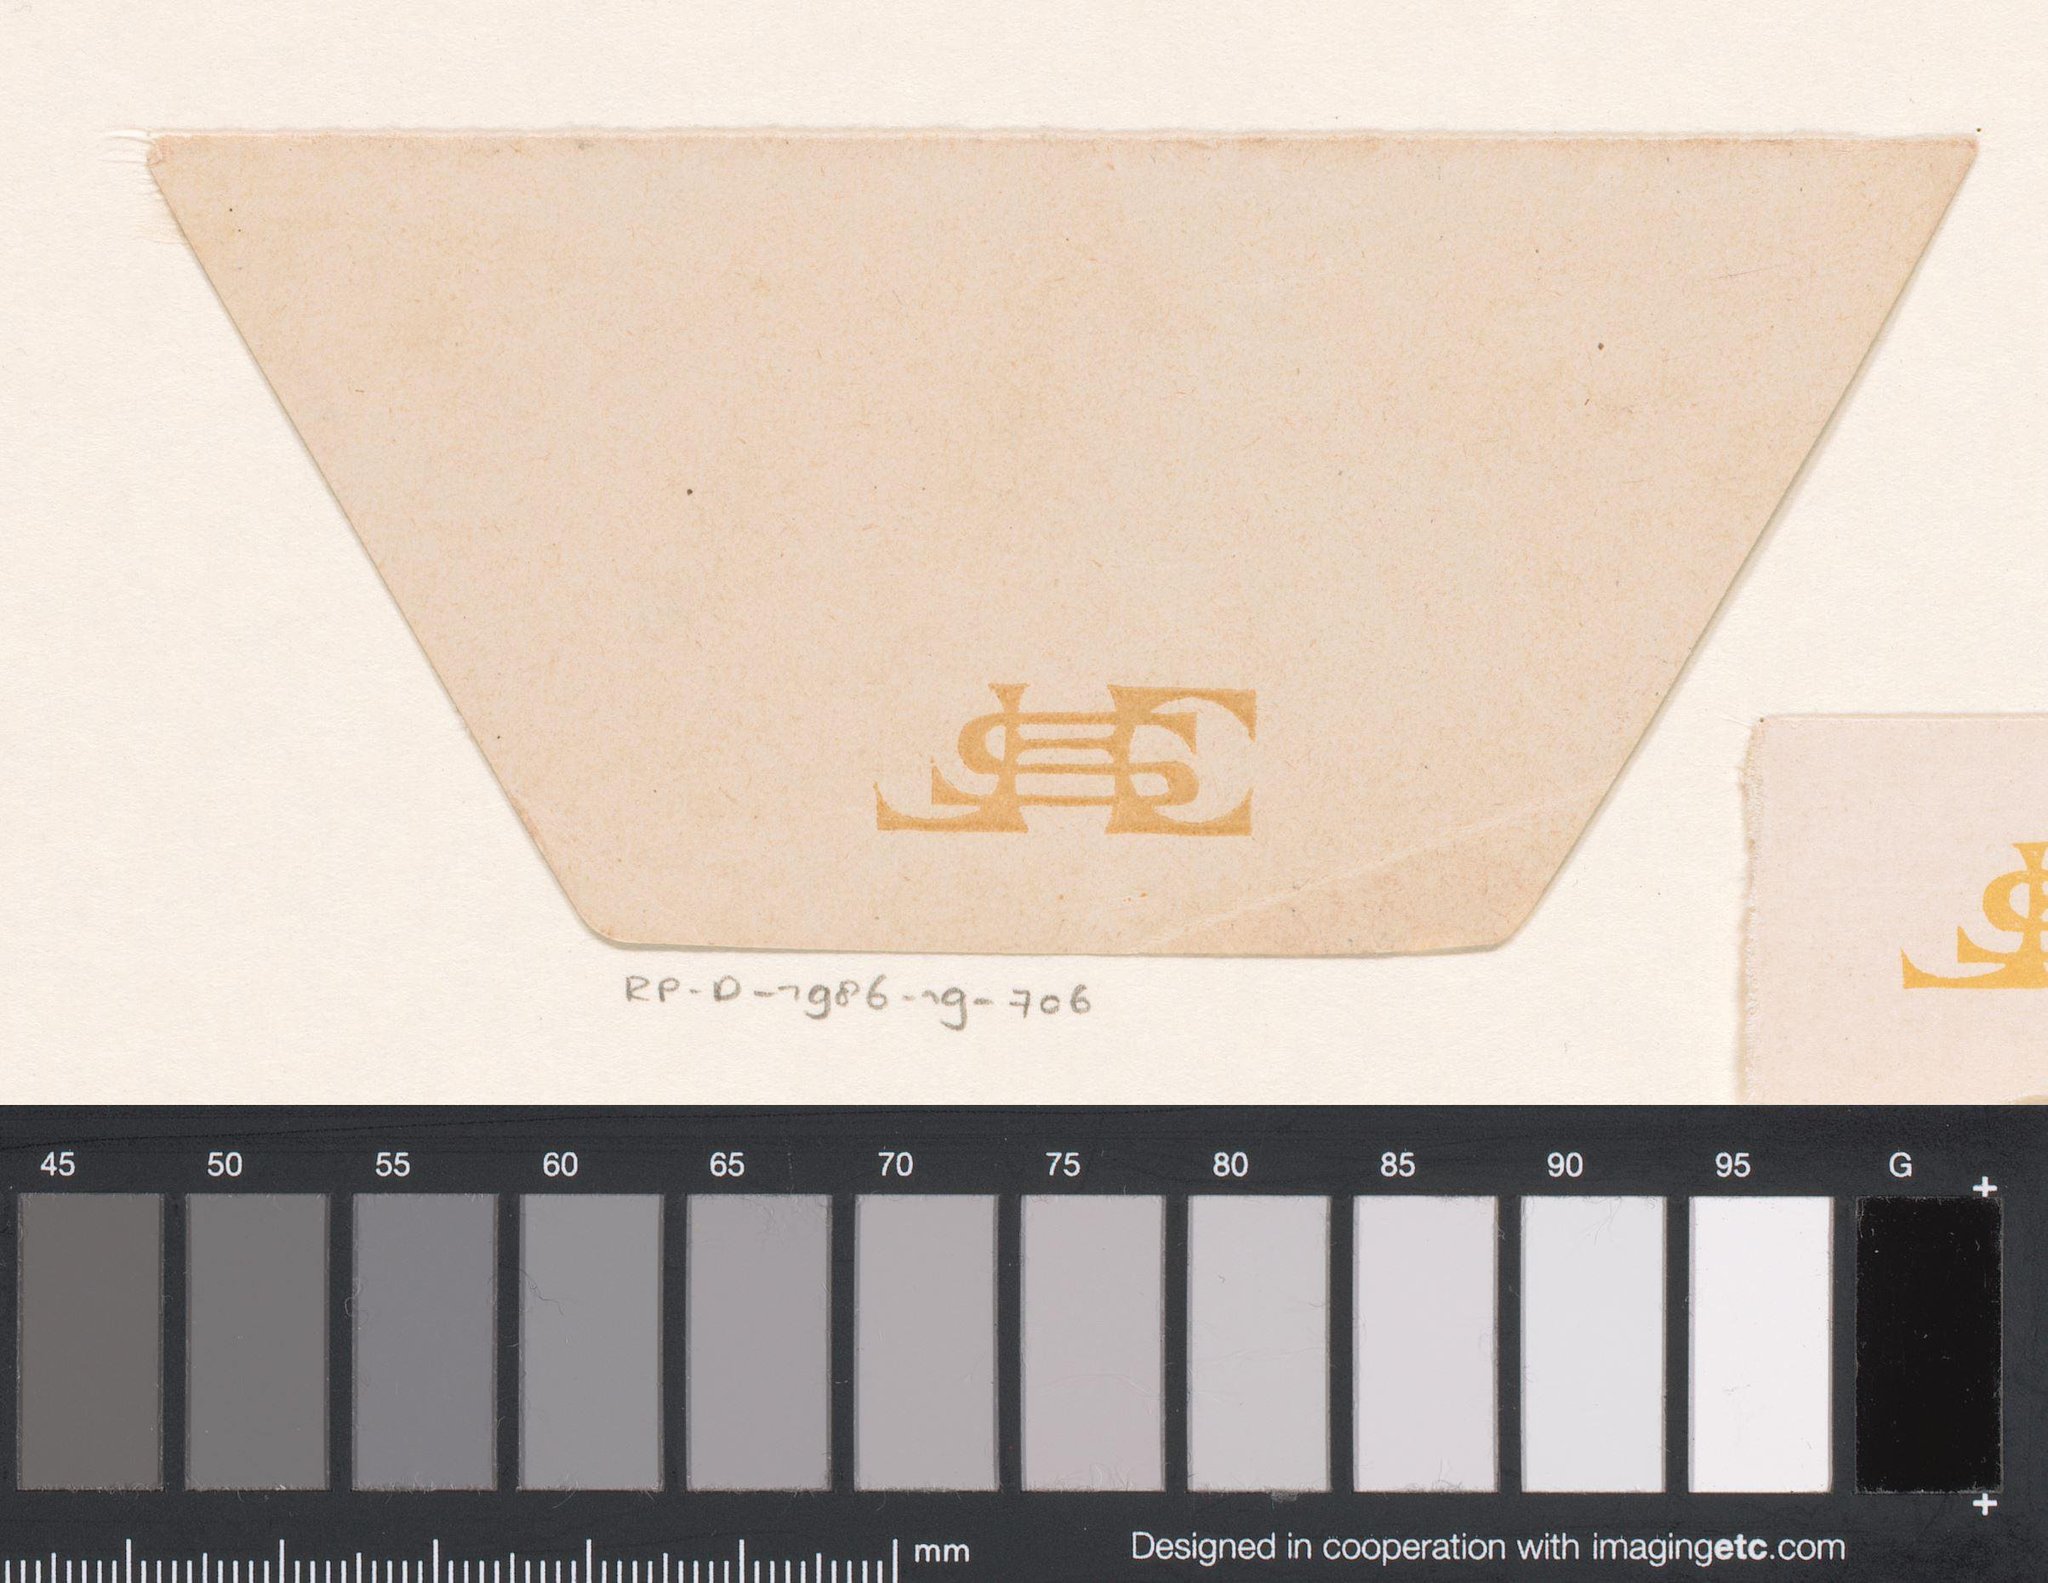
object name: photomechanical print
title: Monogram SHLC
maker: reinier willem petrus de vries (1874-1953)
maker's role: draughtsman, print maker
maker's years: 1874-1953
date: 1884-1952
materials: paper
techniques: printing block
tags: magic mathematical figures; magic numbers, words, monograms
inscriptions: collector's mark: ‘R:MVS.’